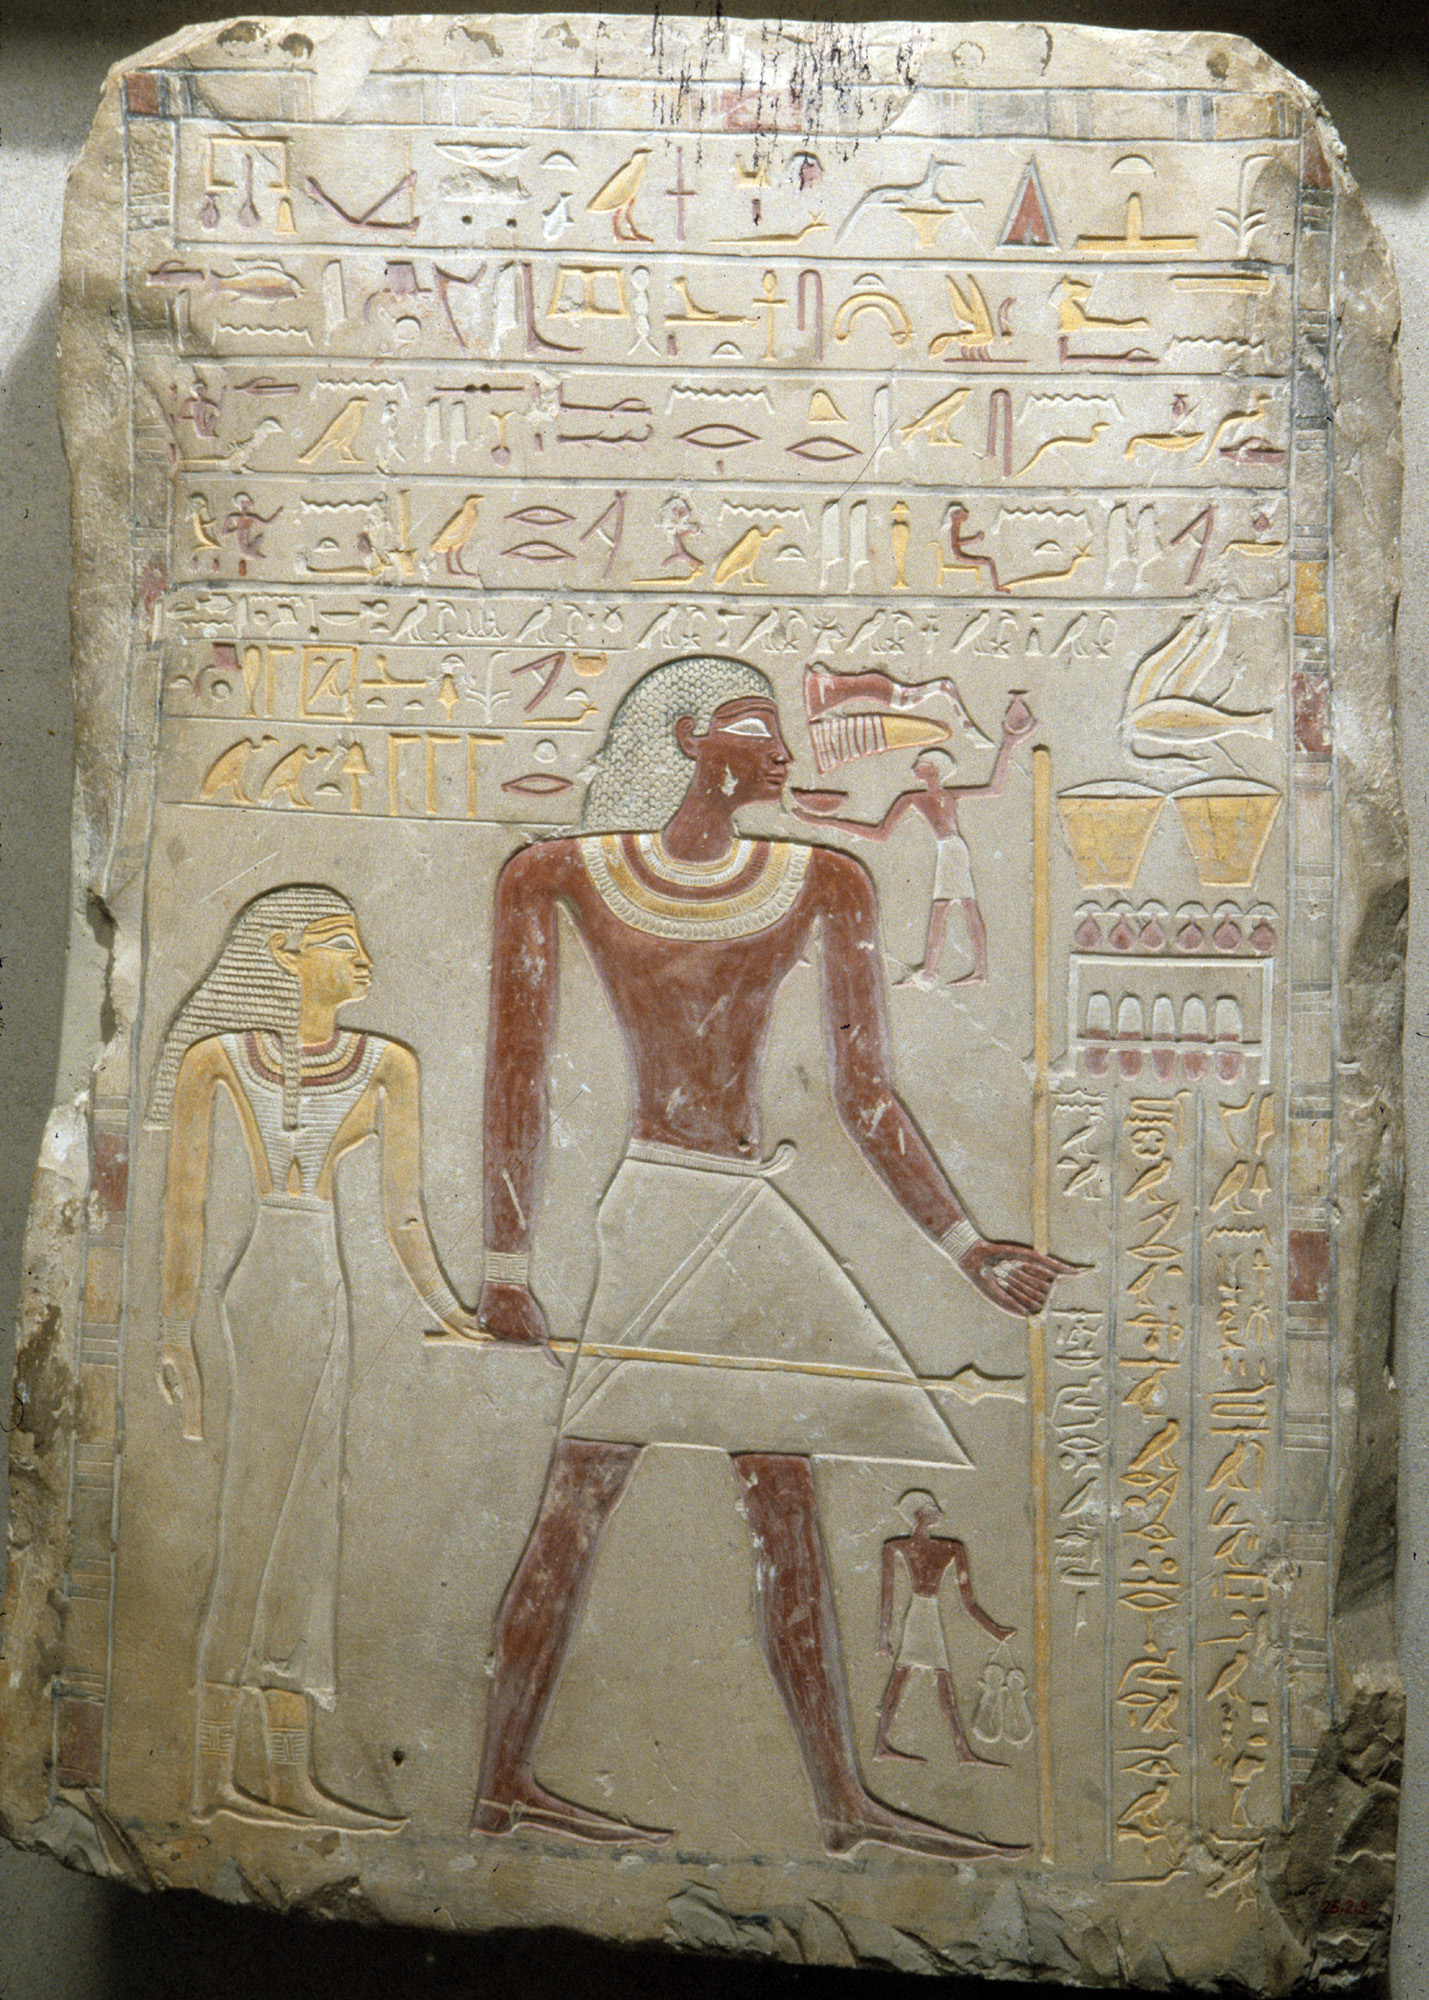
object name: stela, indi and mutmuti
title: Funerary Stela of the Royal Sealer Indi and His Wife, the Priestess of Hathor Mutmuti of Thinis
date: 2100-2090 BCE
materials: limestone, paint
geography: northern upper egypt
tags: men,women,hieroglyphs